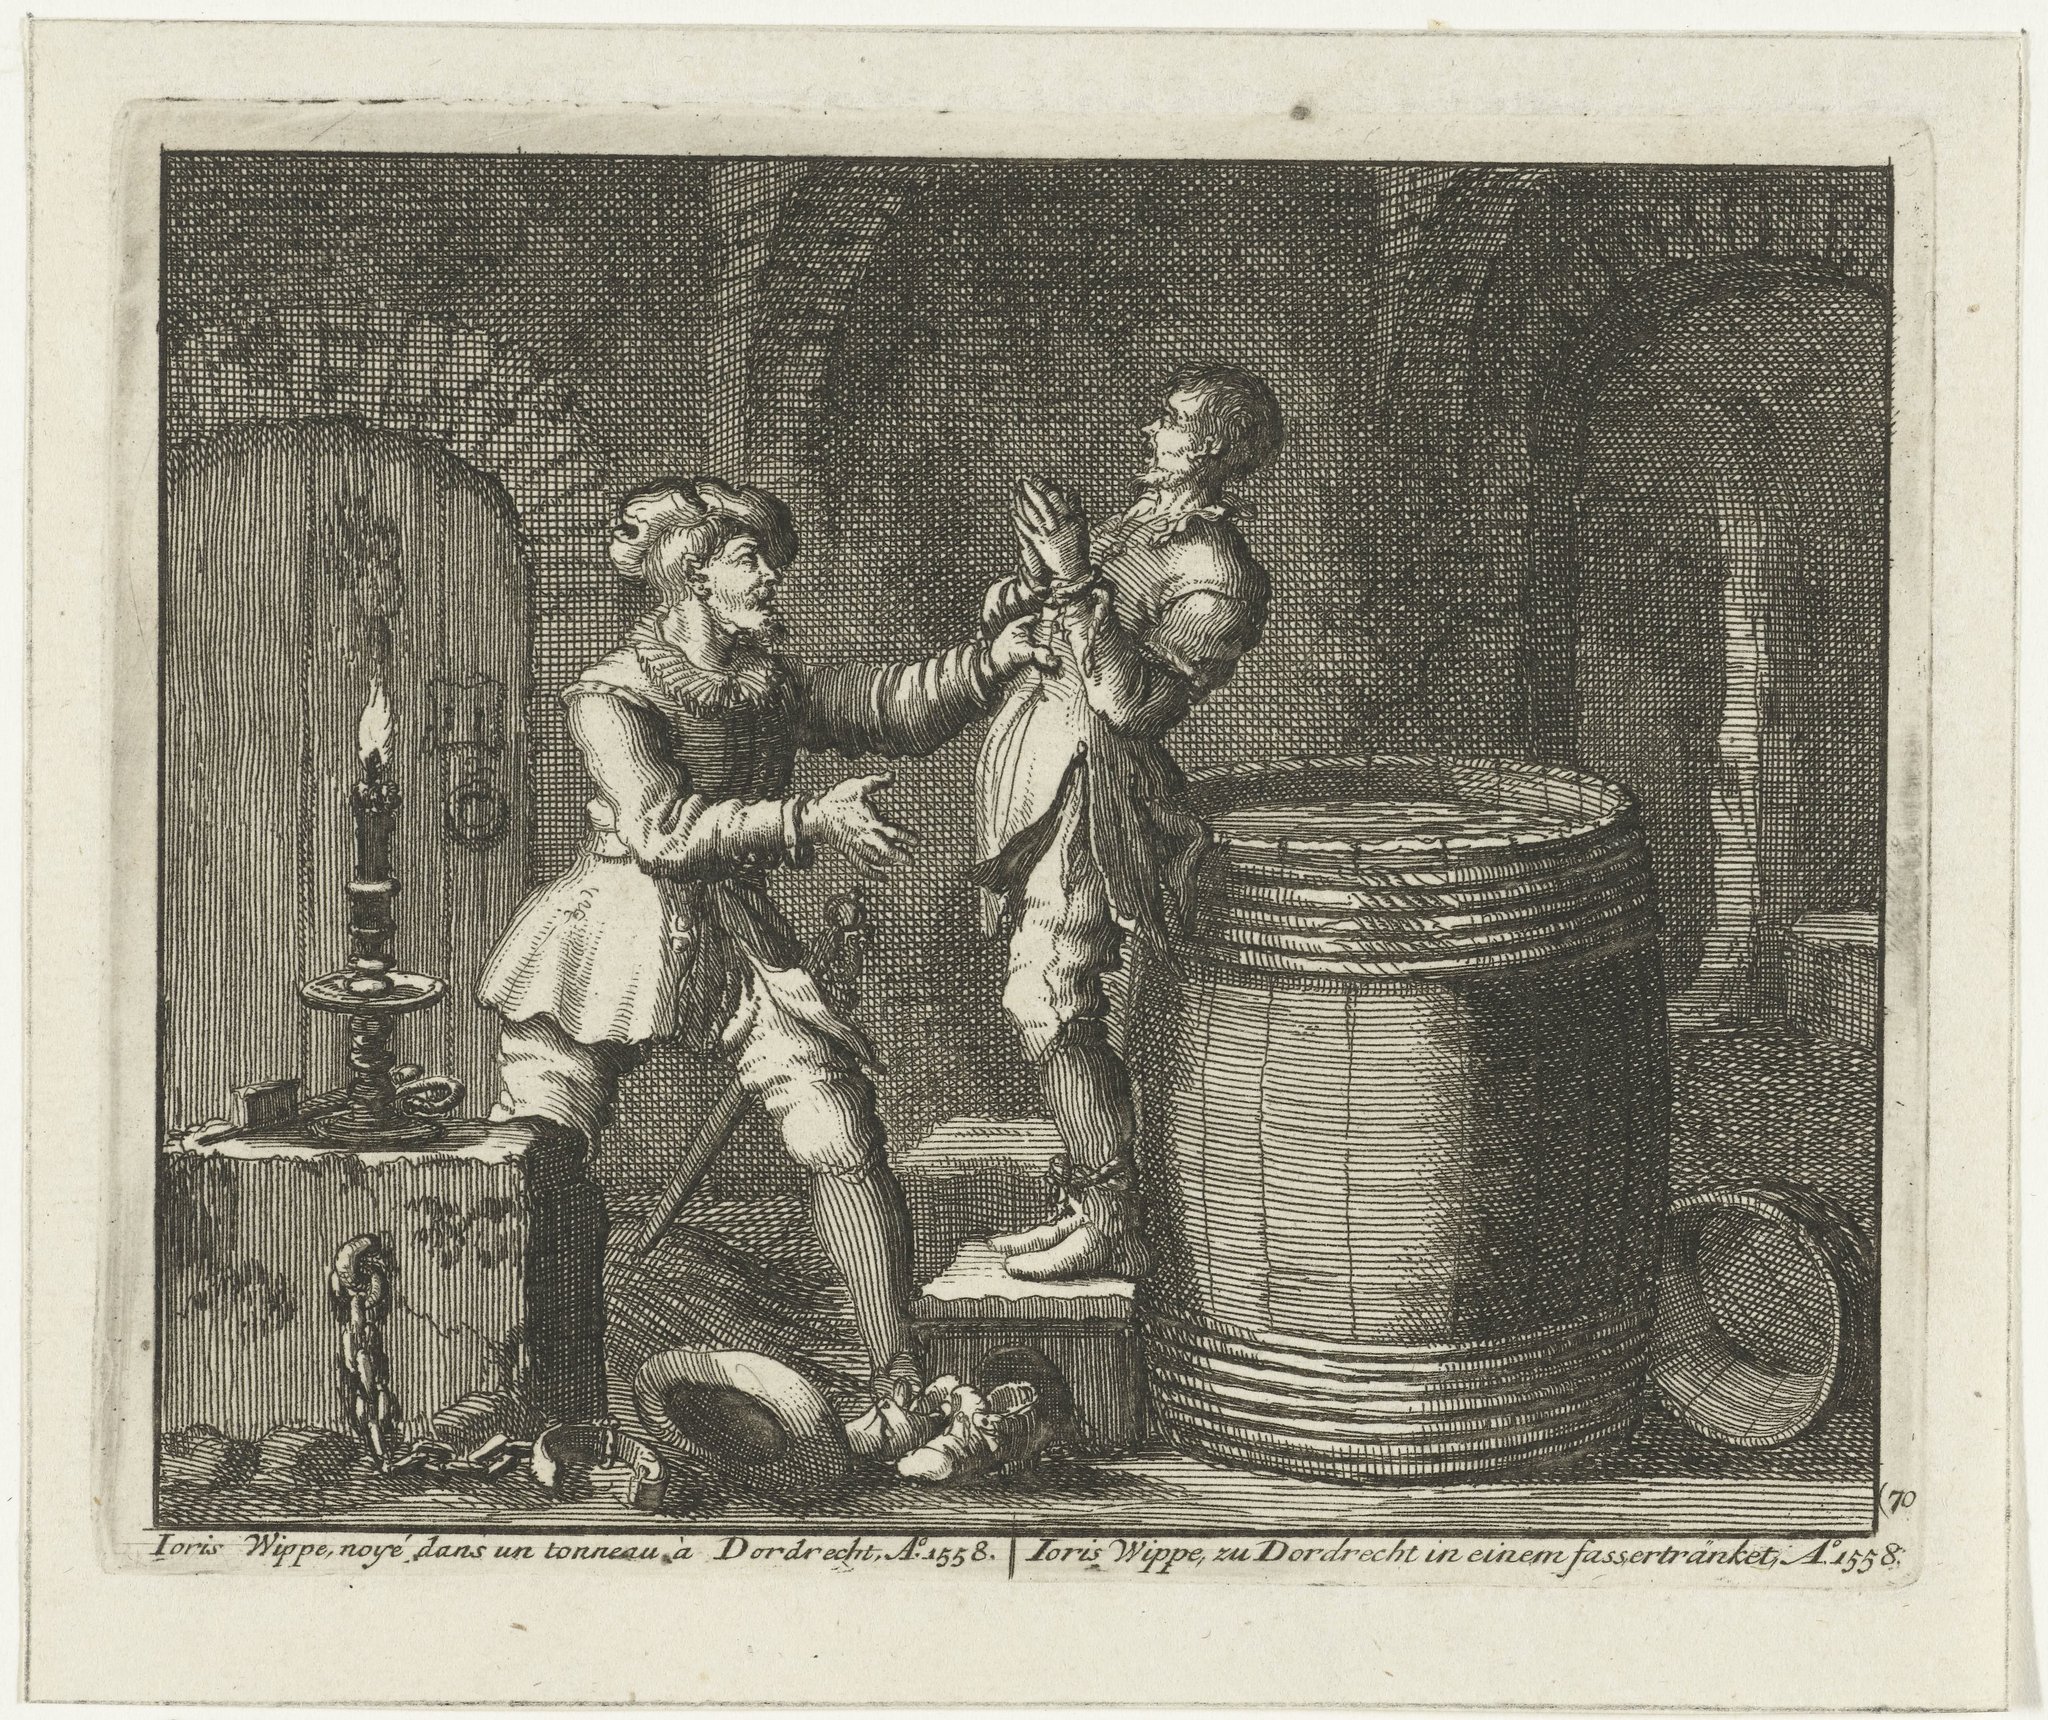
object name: history print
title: Joris Wippe te Dordrecht in een vat verdronken, 1558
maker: jan luyken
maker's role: draughtsman, print maker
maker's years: 1649-1712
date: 1683-1685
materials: paper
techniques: etching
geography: northern netherlands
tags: dordrecht, execution of heretic, e.g. by burning at the stake, 'auto-da-fé'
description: Deze prentn in de tweede staat gebruikt als illustratie voor: Theatre des martyrs, depuis la mort de J. Christ jusqu'à present (...). = Schau-buhne der Martyrer, P. van der Aa, Leiden ca. 1715, nr. 70. De prenten zijn oorspronkelijk vervaardigd voor en eerst gebruikt in: T.J. van Bragt, Het bloedig tooneel, of Martelaers spiegel der doops-gesinde of weereloose christenen, 1685.